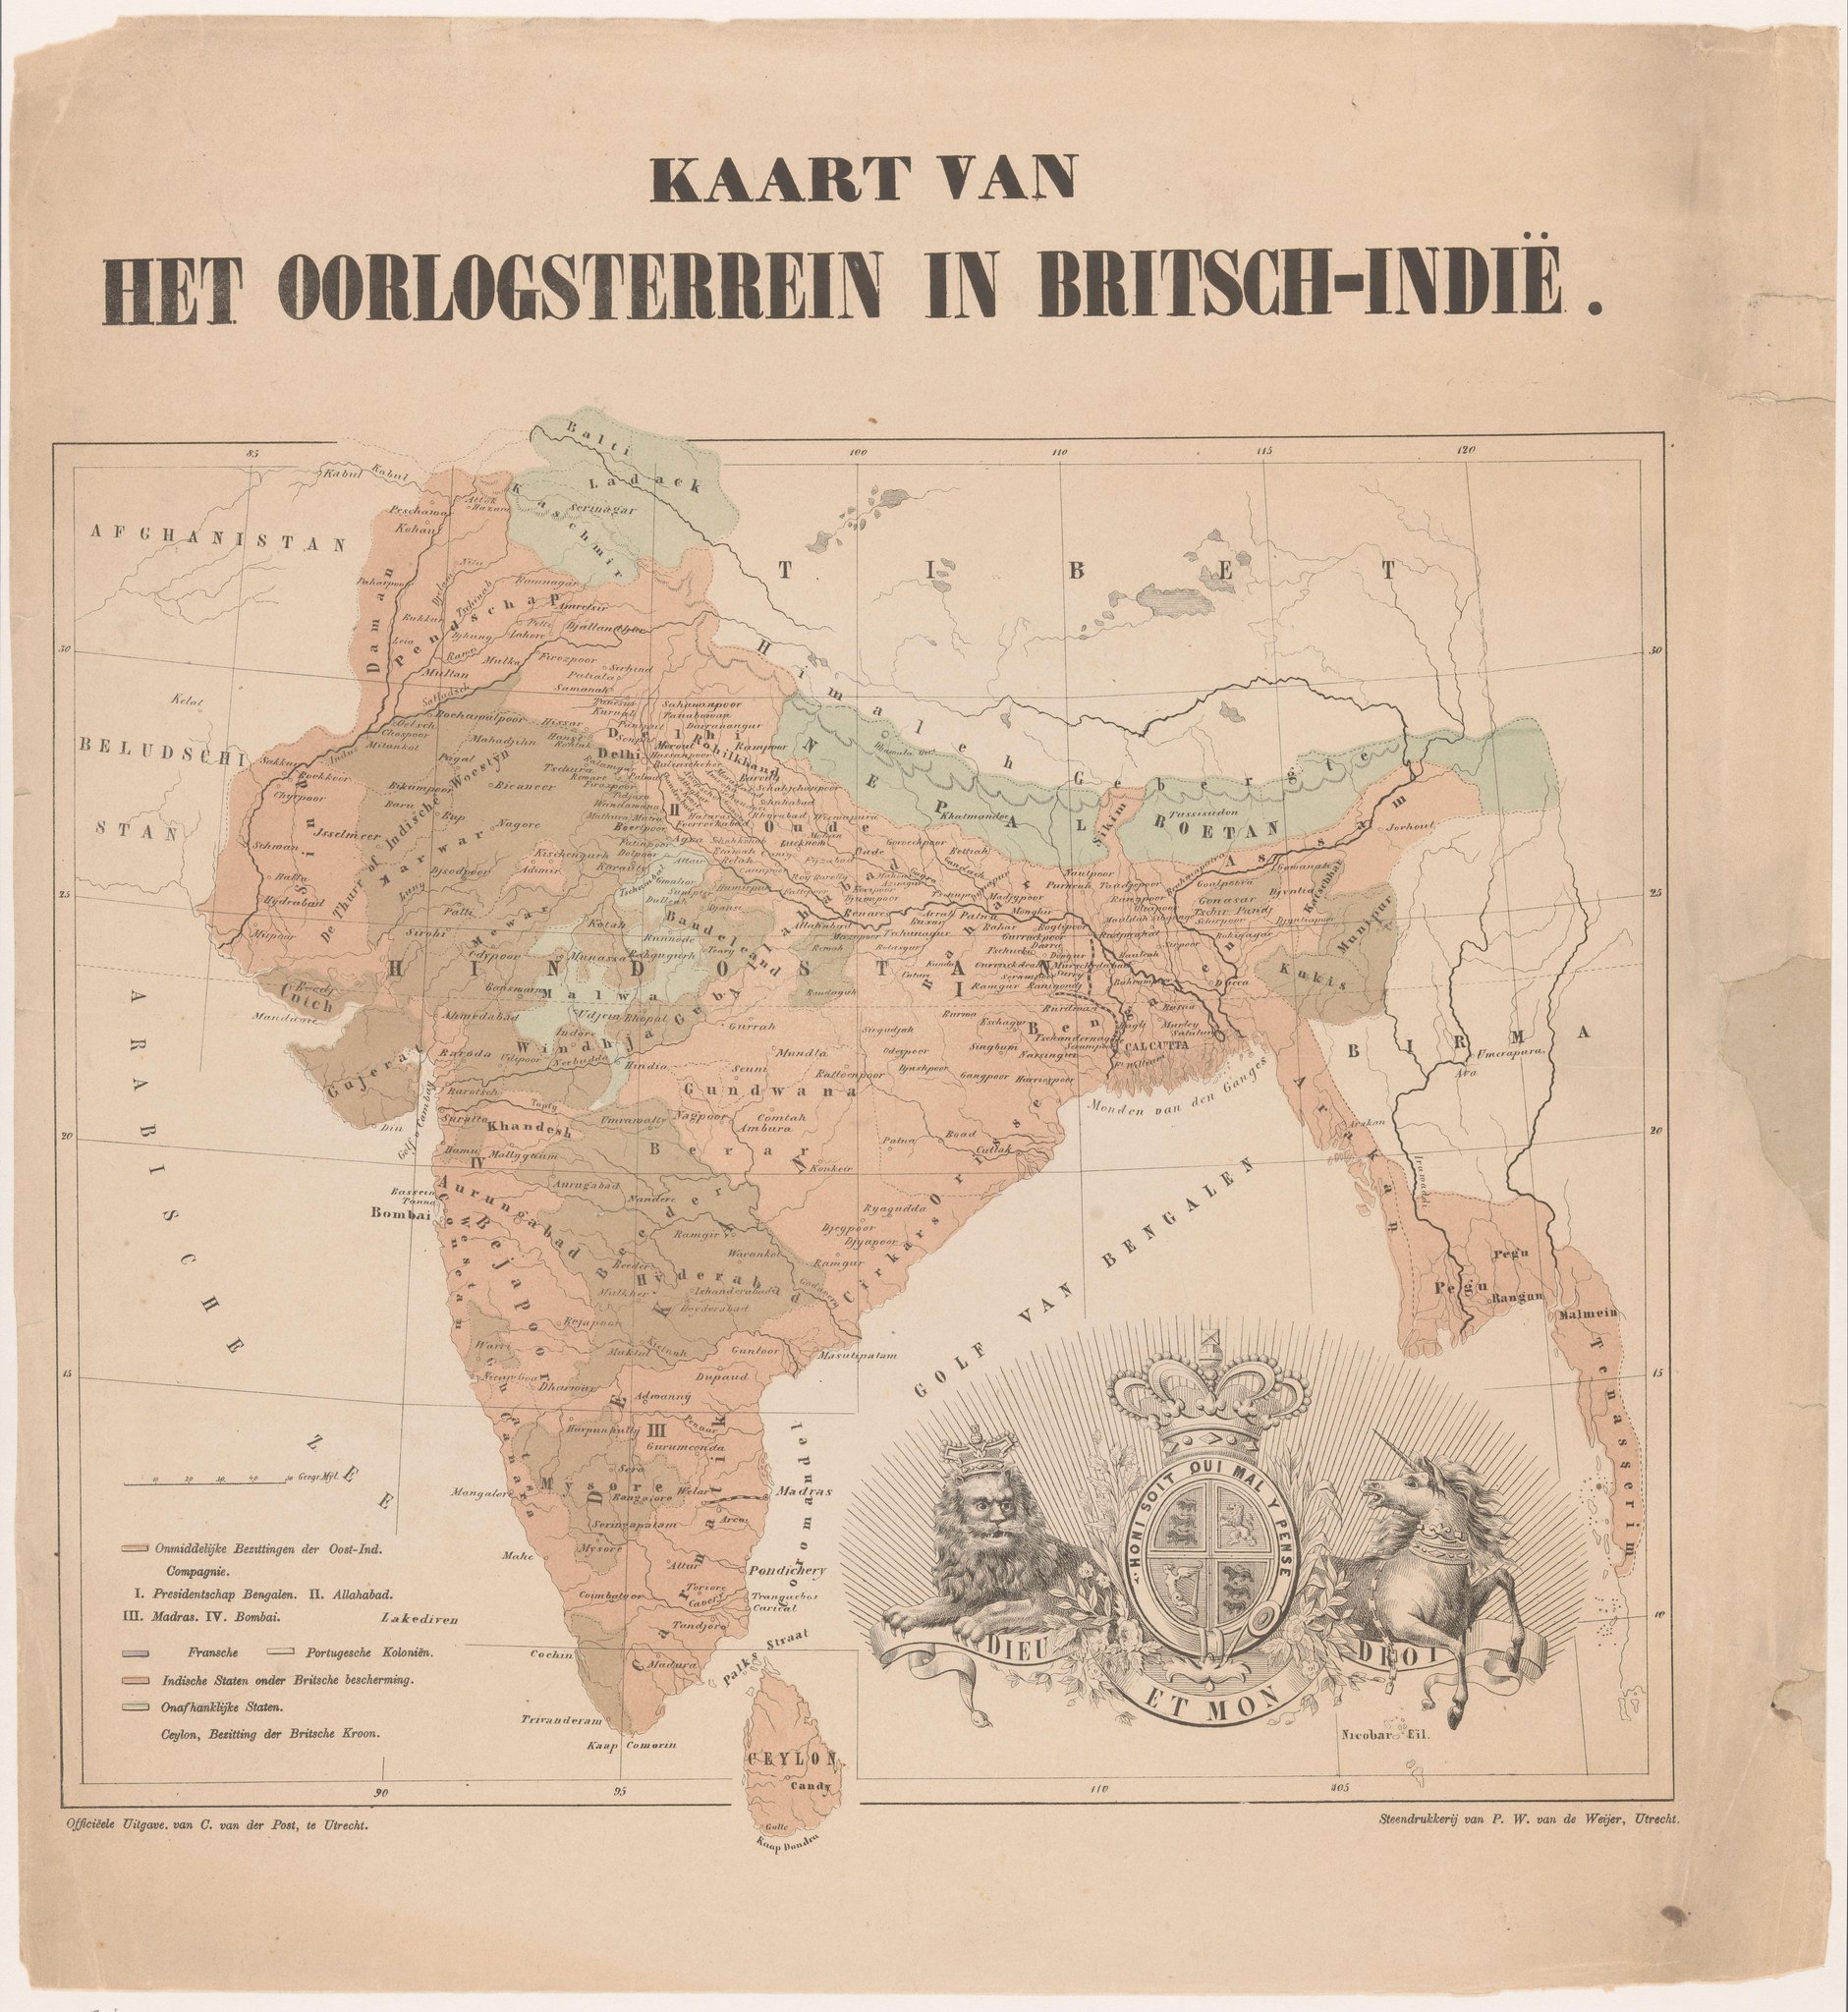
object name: map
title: Kaart van het oorlogsterrein in Britsch-Indië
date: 1830-1879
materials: paper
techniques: lithograph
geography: utrecht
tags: imperialism, maps of separate countries or regions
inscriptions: collector's mark: Lugt 2228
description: Onderin de afbeelding het wapen van het Verenigd Koninkrijk.